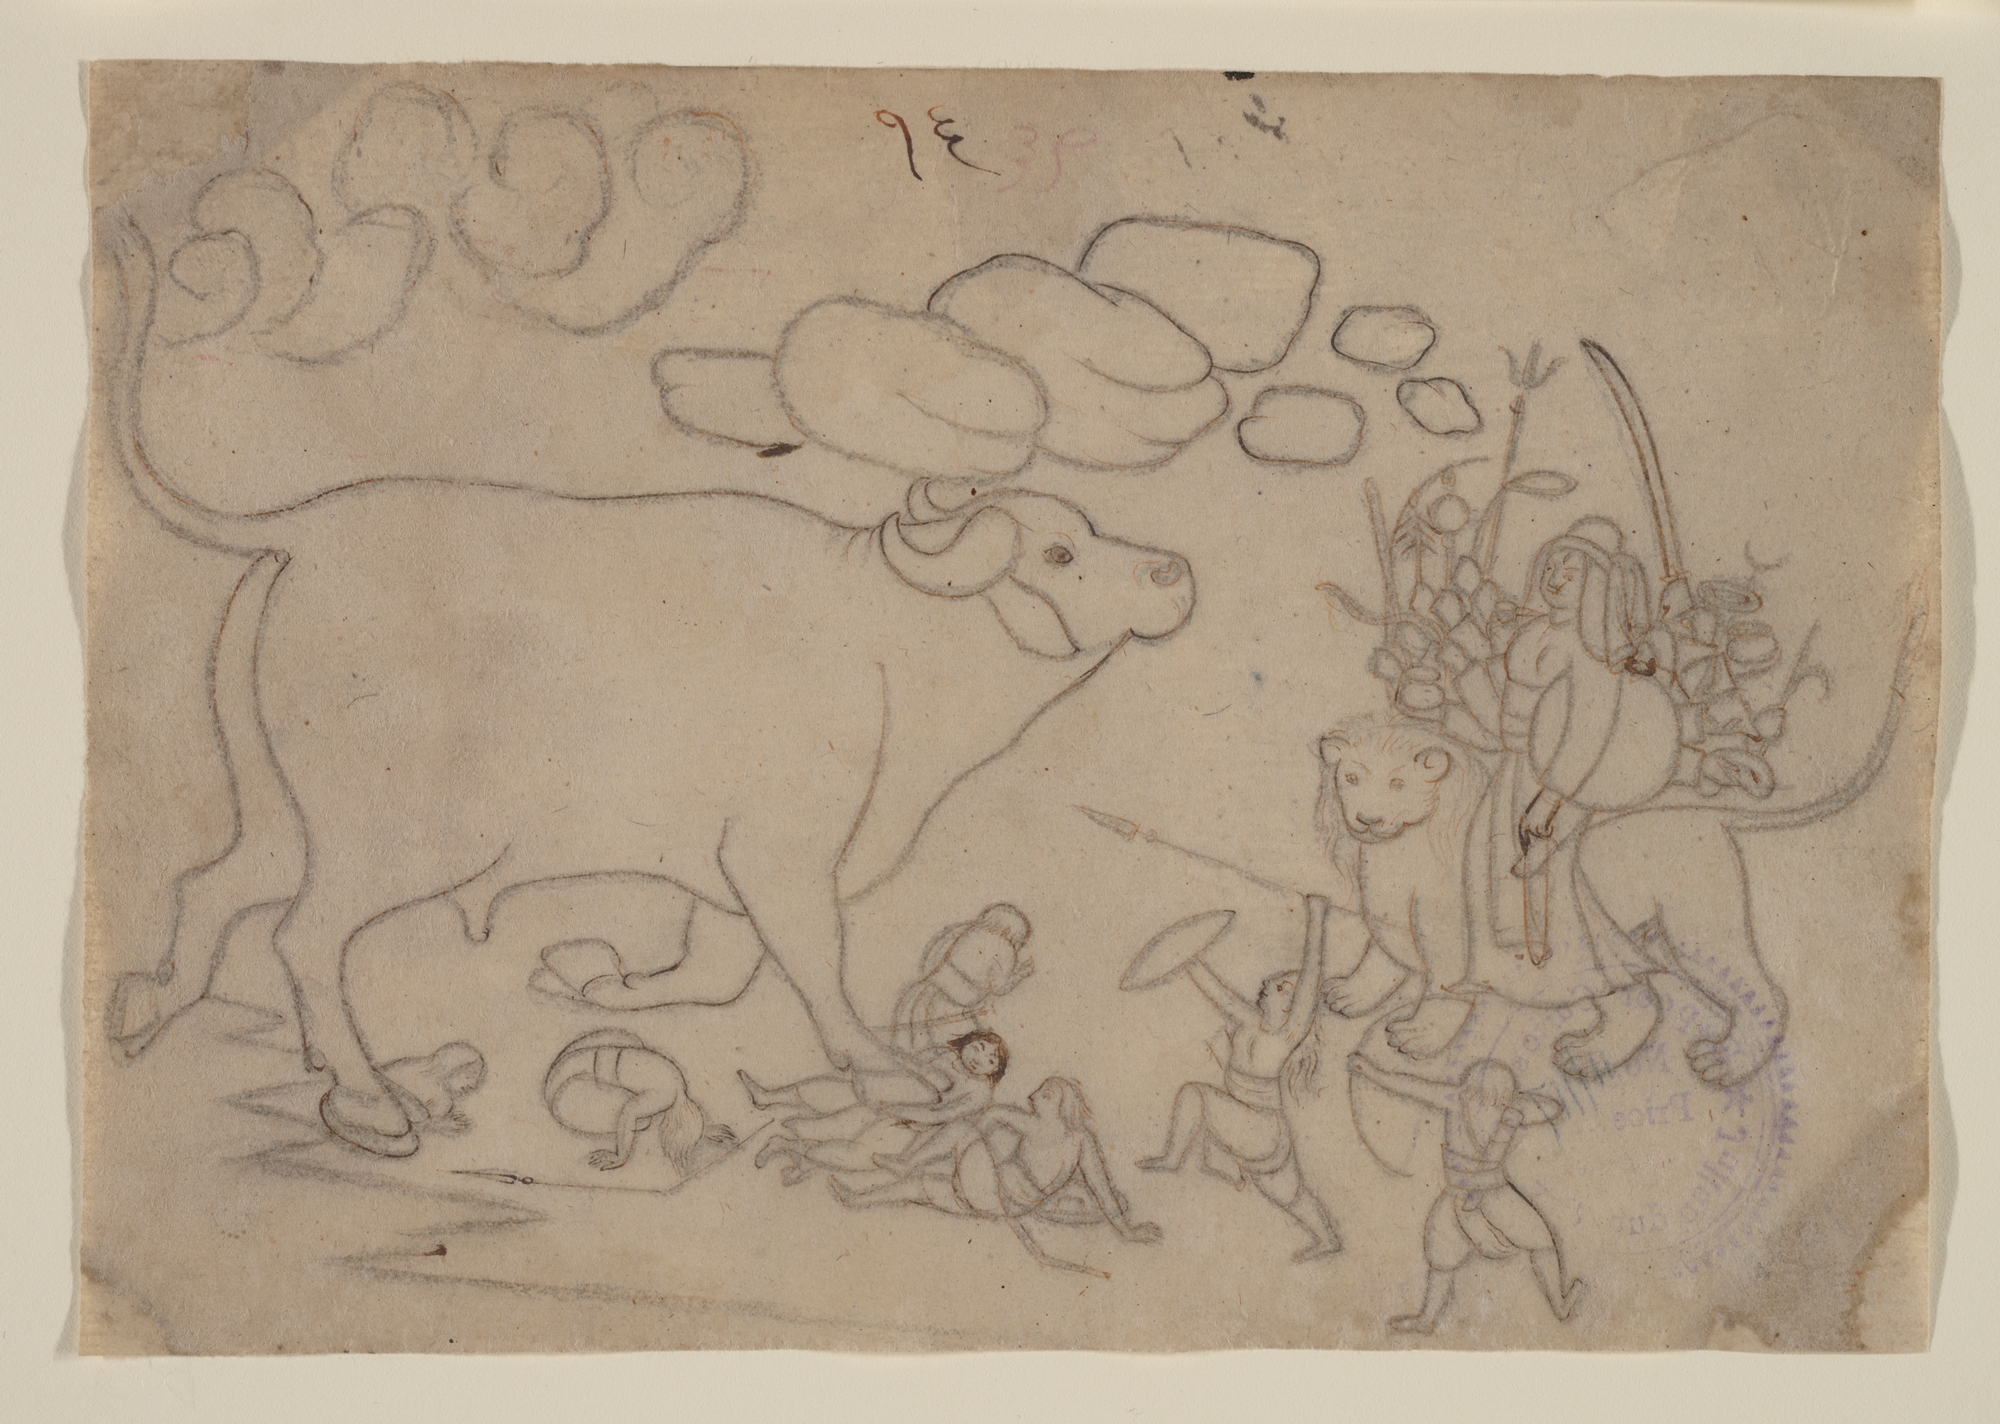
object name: painting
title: Durga Confronts the Buffalo Demon Mahisha: Scene from the Devi Mahatmya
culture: indian, guler, himachal pradesh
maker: nainsukh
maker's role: artist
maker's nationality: indian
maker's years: 1725-1778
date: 1780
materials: charcoal, paper, watercolor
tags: buffalos,lions,demons,durga